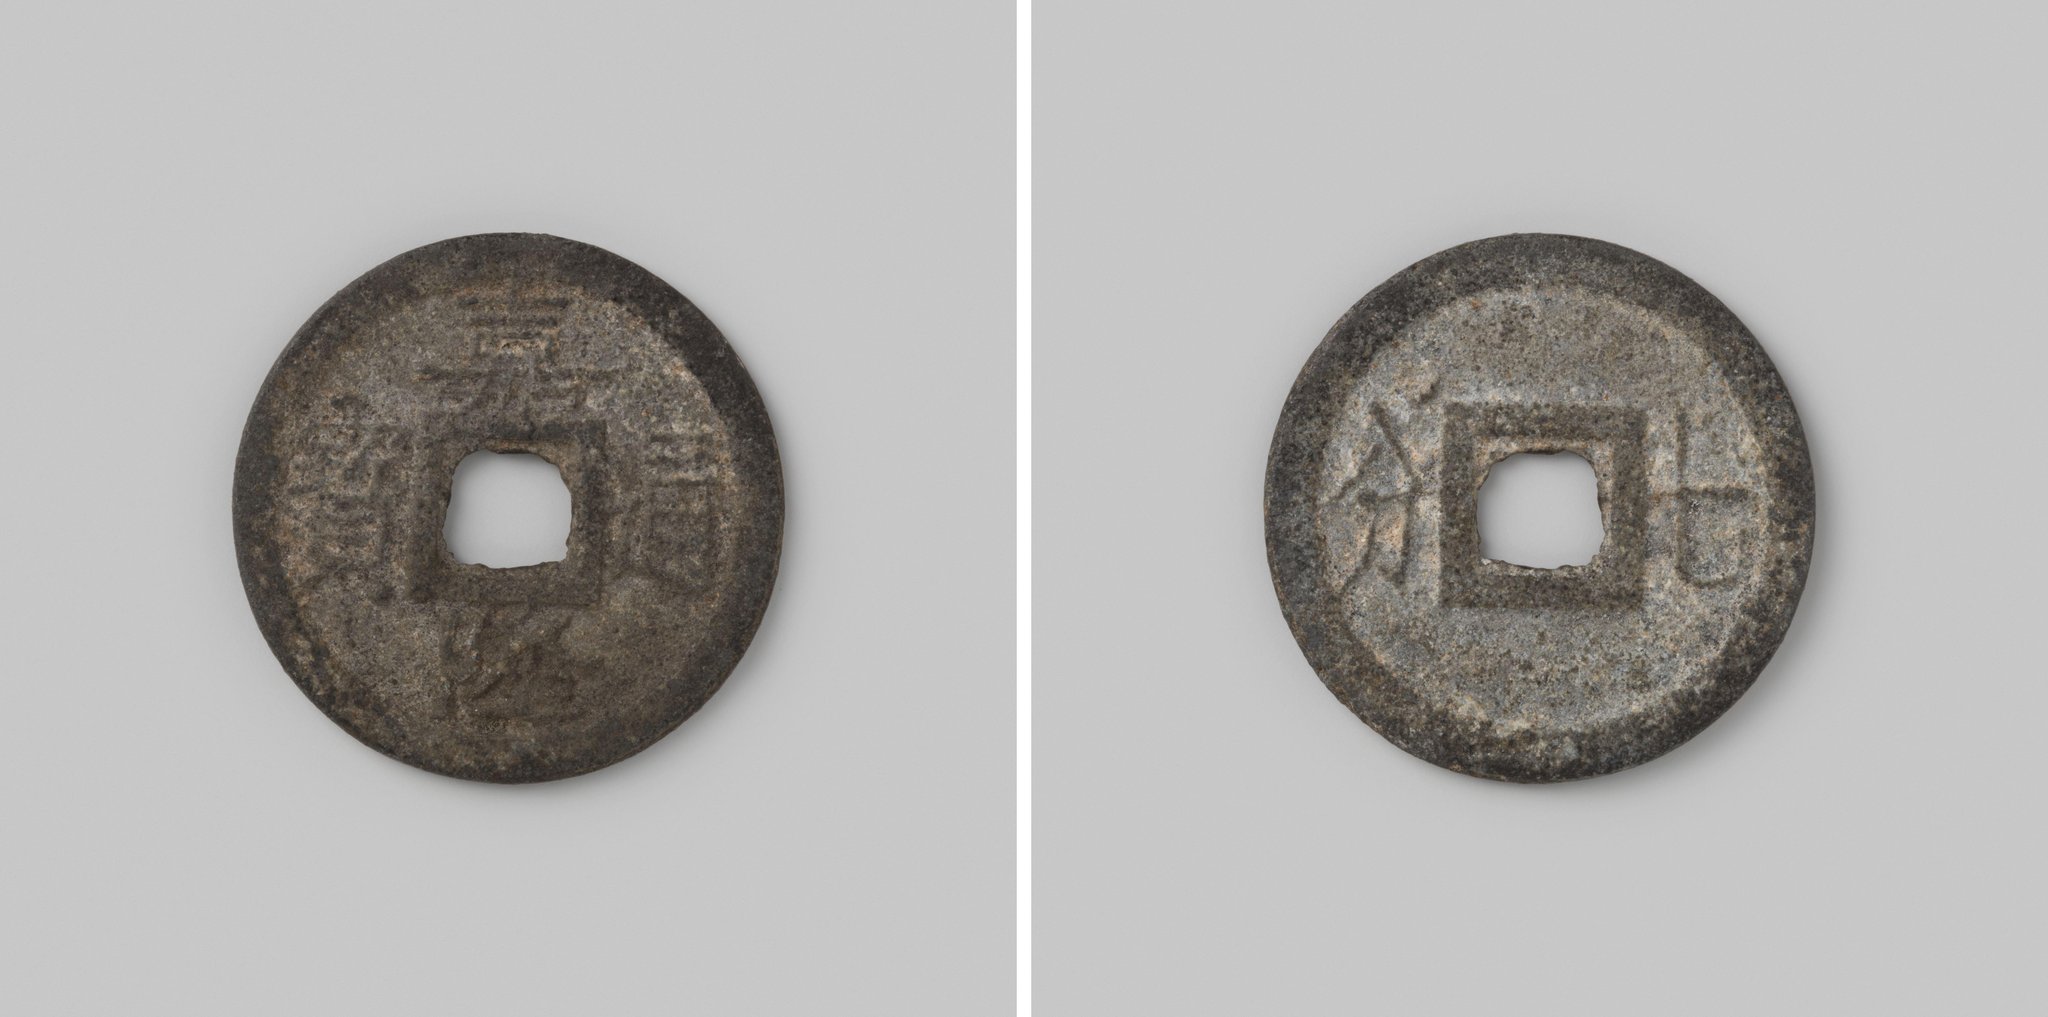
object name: coin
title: Sapeka uit het keizerrijk Annam van Nguyen phuoc-anh,1801-1820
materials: tin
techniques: striking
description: Tinnen munt. Voorzijde: vier Chinese karakters rodom vierkante uitsparing in het midden. Keerzijde: twee Chinese karakters rodom vierkante uitsparing in het midden.